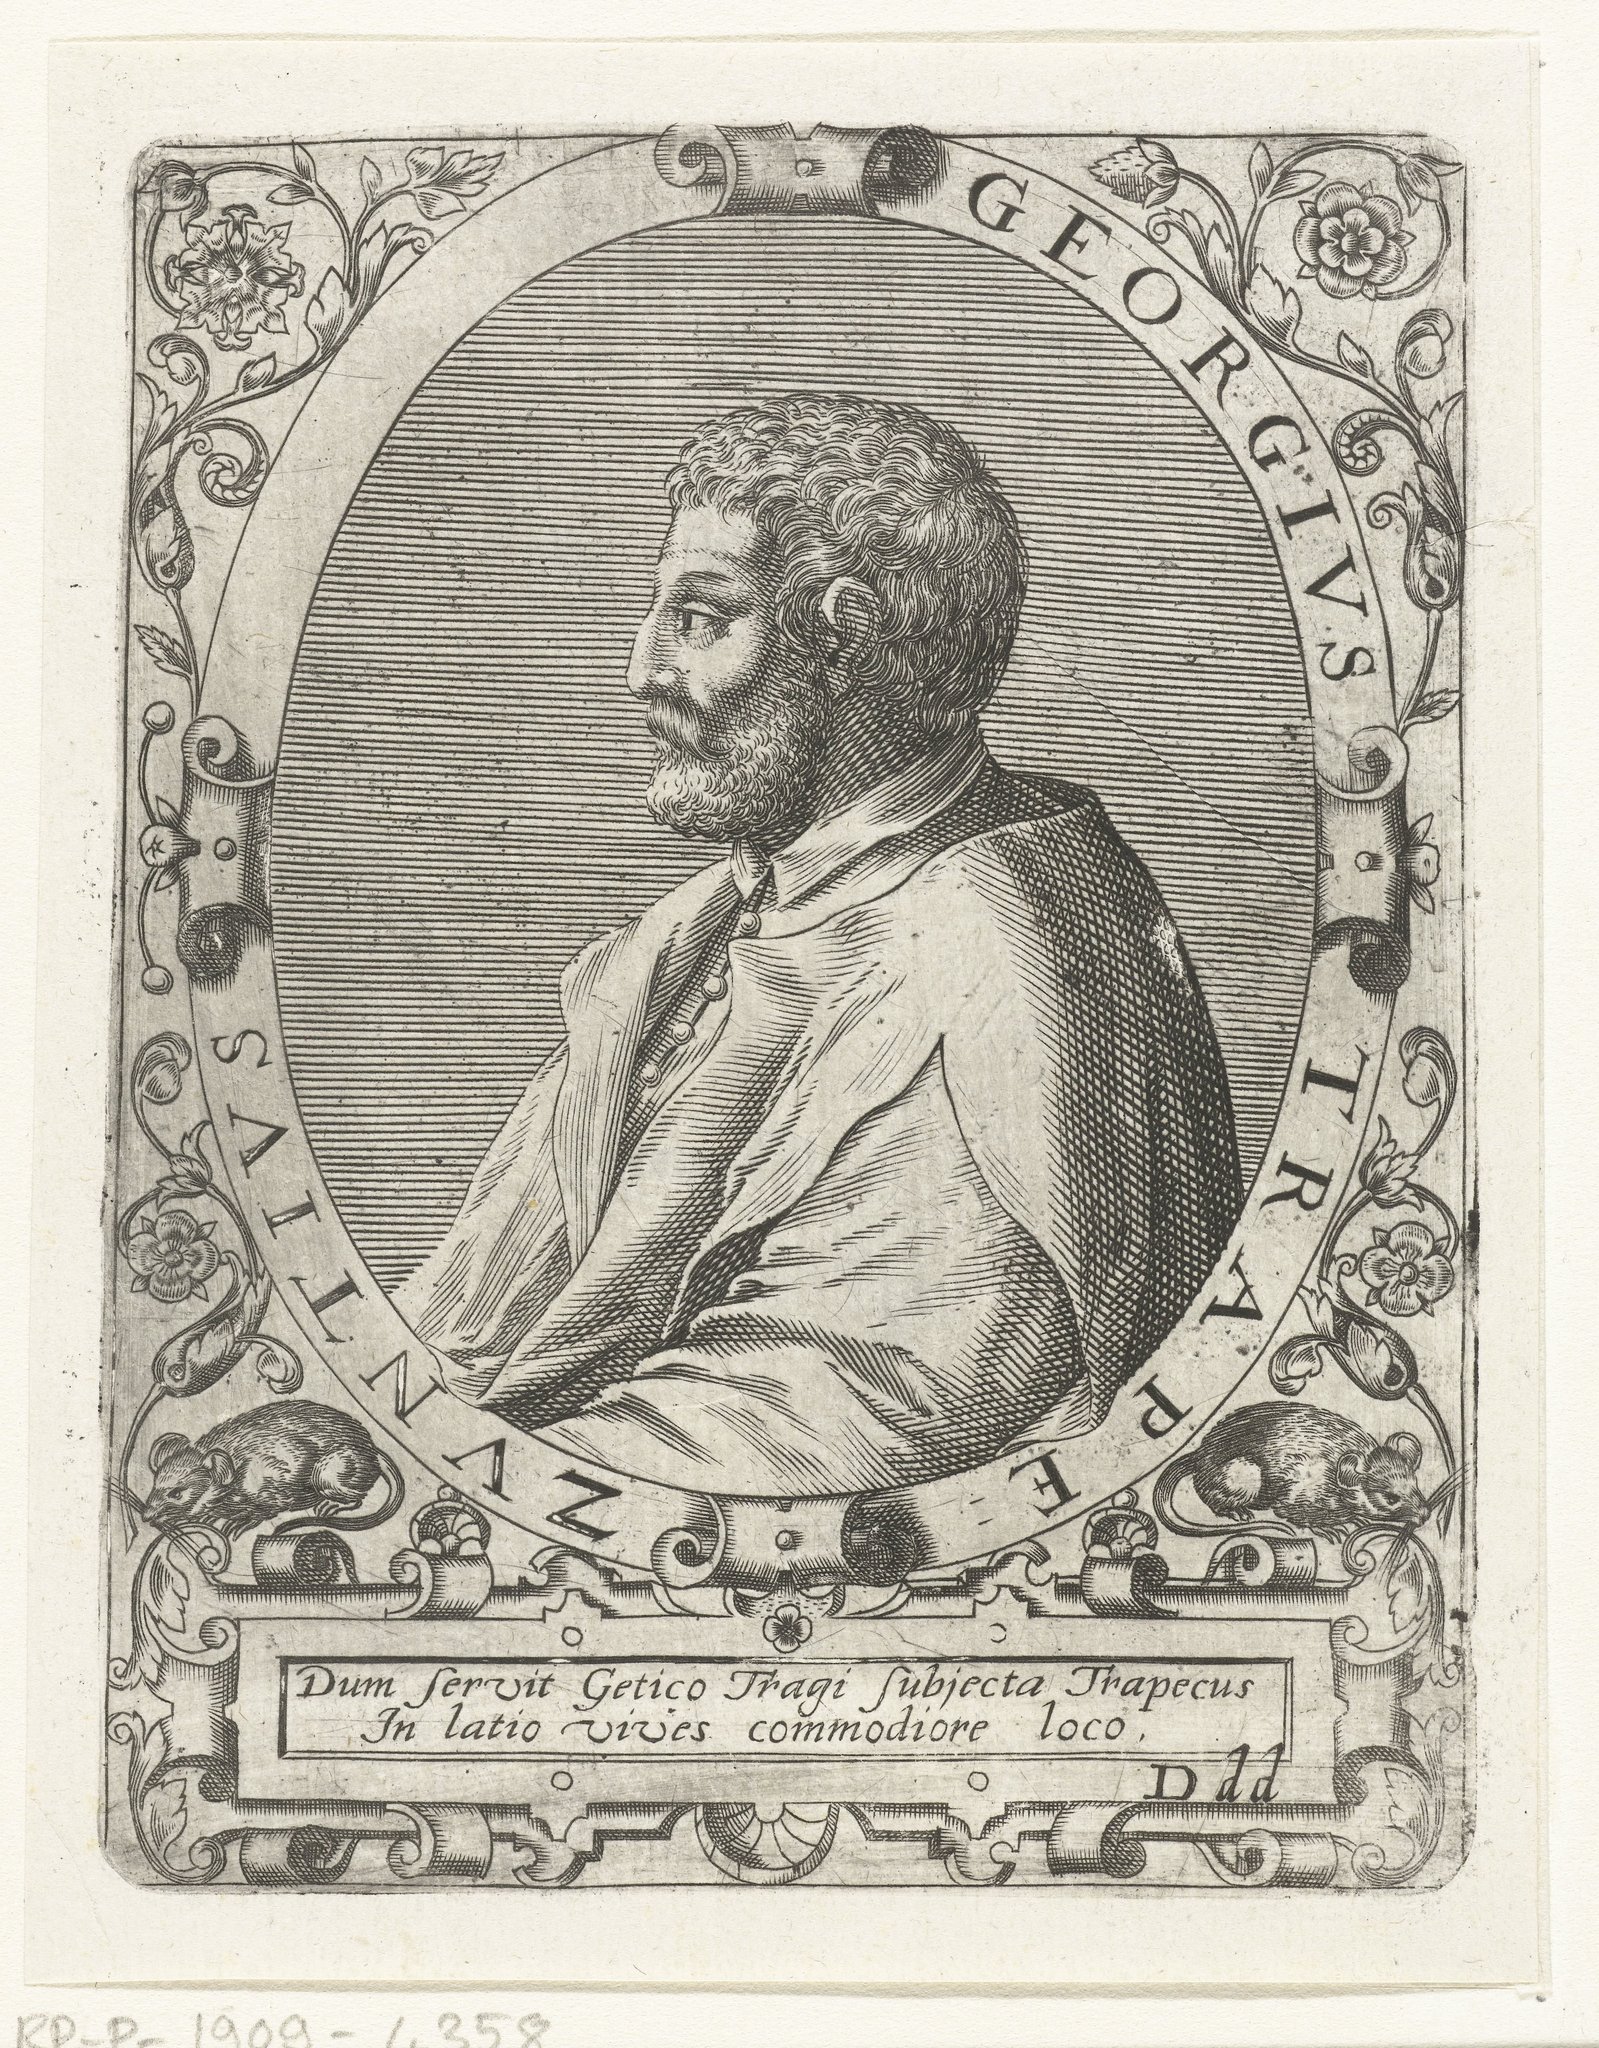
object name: book illustration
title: Georg Trapezuntius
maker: jean jacques boissard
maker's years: 1528-1598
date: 1669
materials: paper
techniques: engraving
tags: kreta, filosoof, geleerde, georgios trapezuntios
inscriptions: collector's mark: Lugt 2228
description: Gemaakt voor: J.J. Boissard, Icones virorum illustrium doctrina &c eruditione praestanti um contines. Frankfurt am Main: de Bry, 1597-1599. Opnieuw gebruikt in: J.J.Boissard, Bibliotheca chalcographica, hoc est Virtute et eruditione clarorum Virorum Imagines. Heidelberg: Clemens Ammon, 1669. Dl. 1-5 (te herkennen aan de toegevoegde signatuur in de rechter onderhoek: 3D).